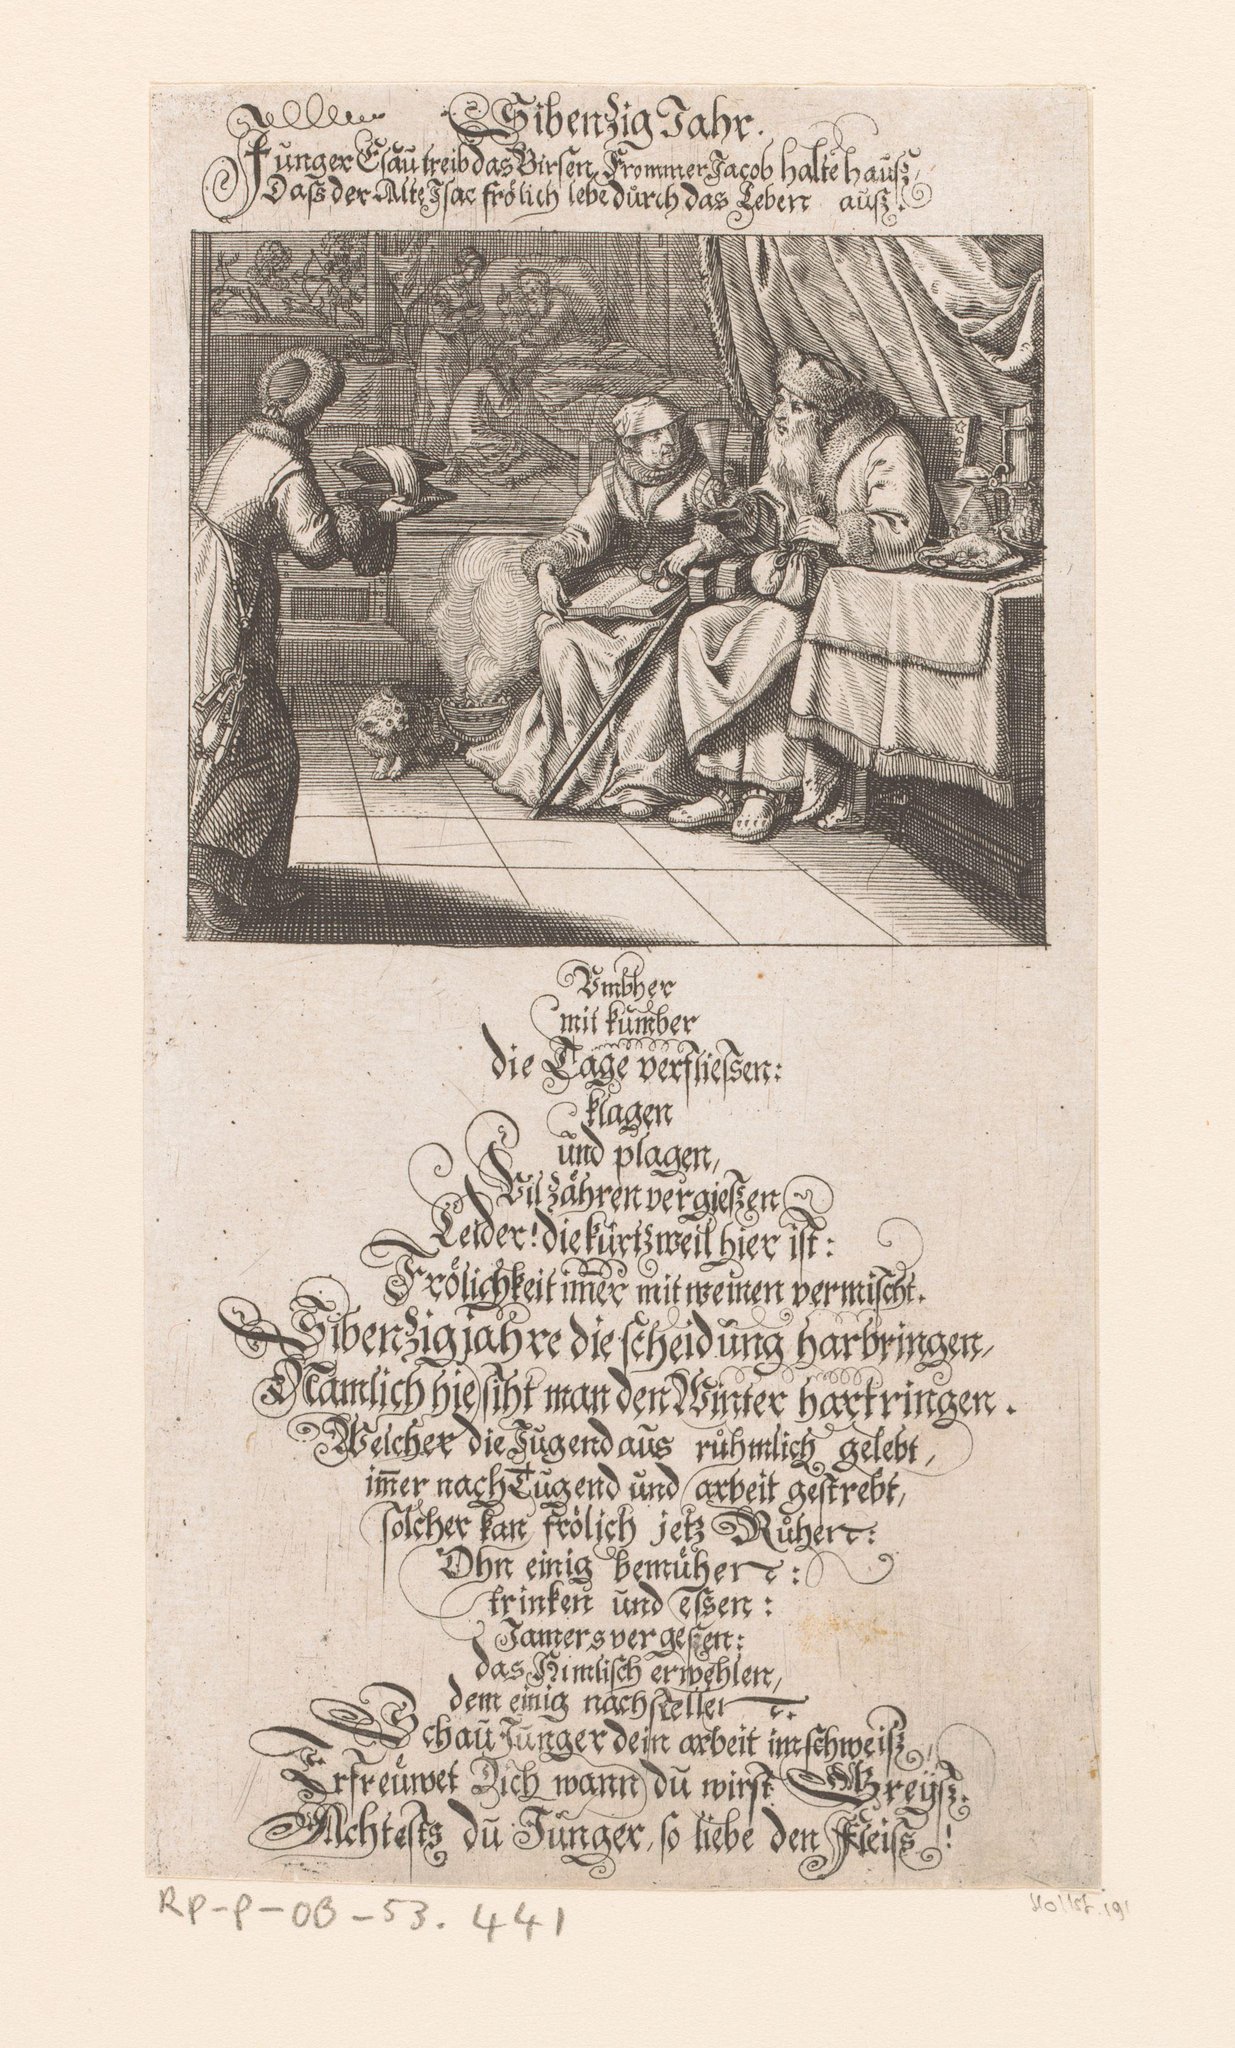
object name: print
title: De leeftijden van de mens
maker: conrad meyer (i)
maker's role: painter, print maker, publisher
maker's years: 1618-1689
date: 1675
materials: paper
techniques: etching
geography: zurich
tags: human life and its ages (young, adult, old, etc.), evening meal, dinner, supper